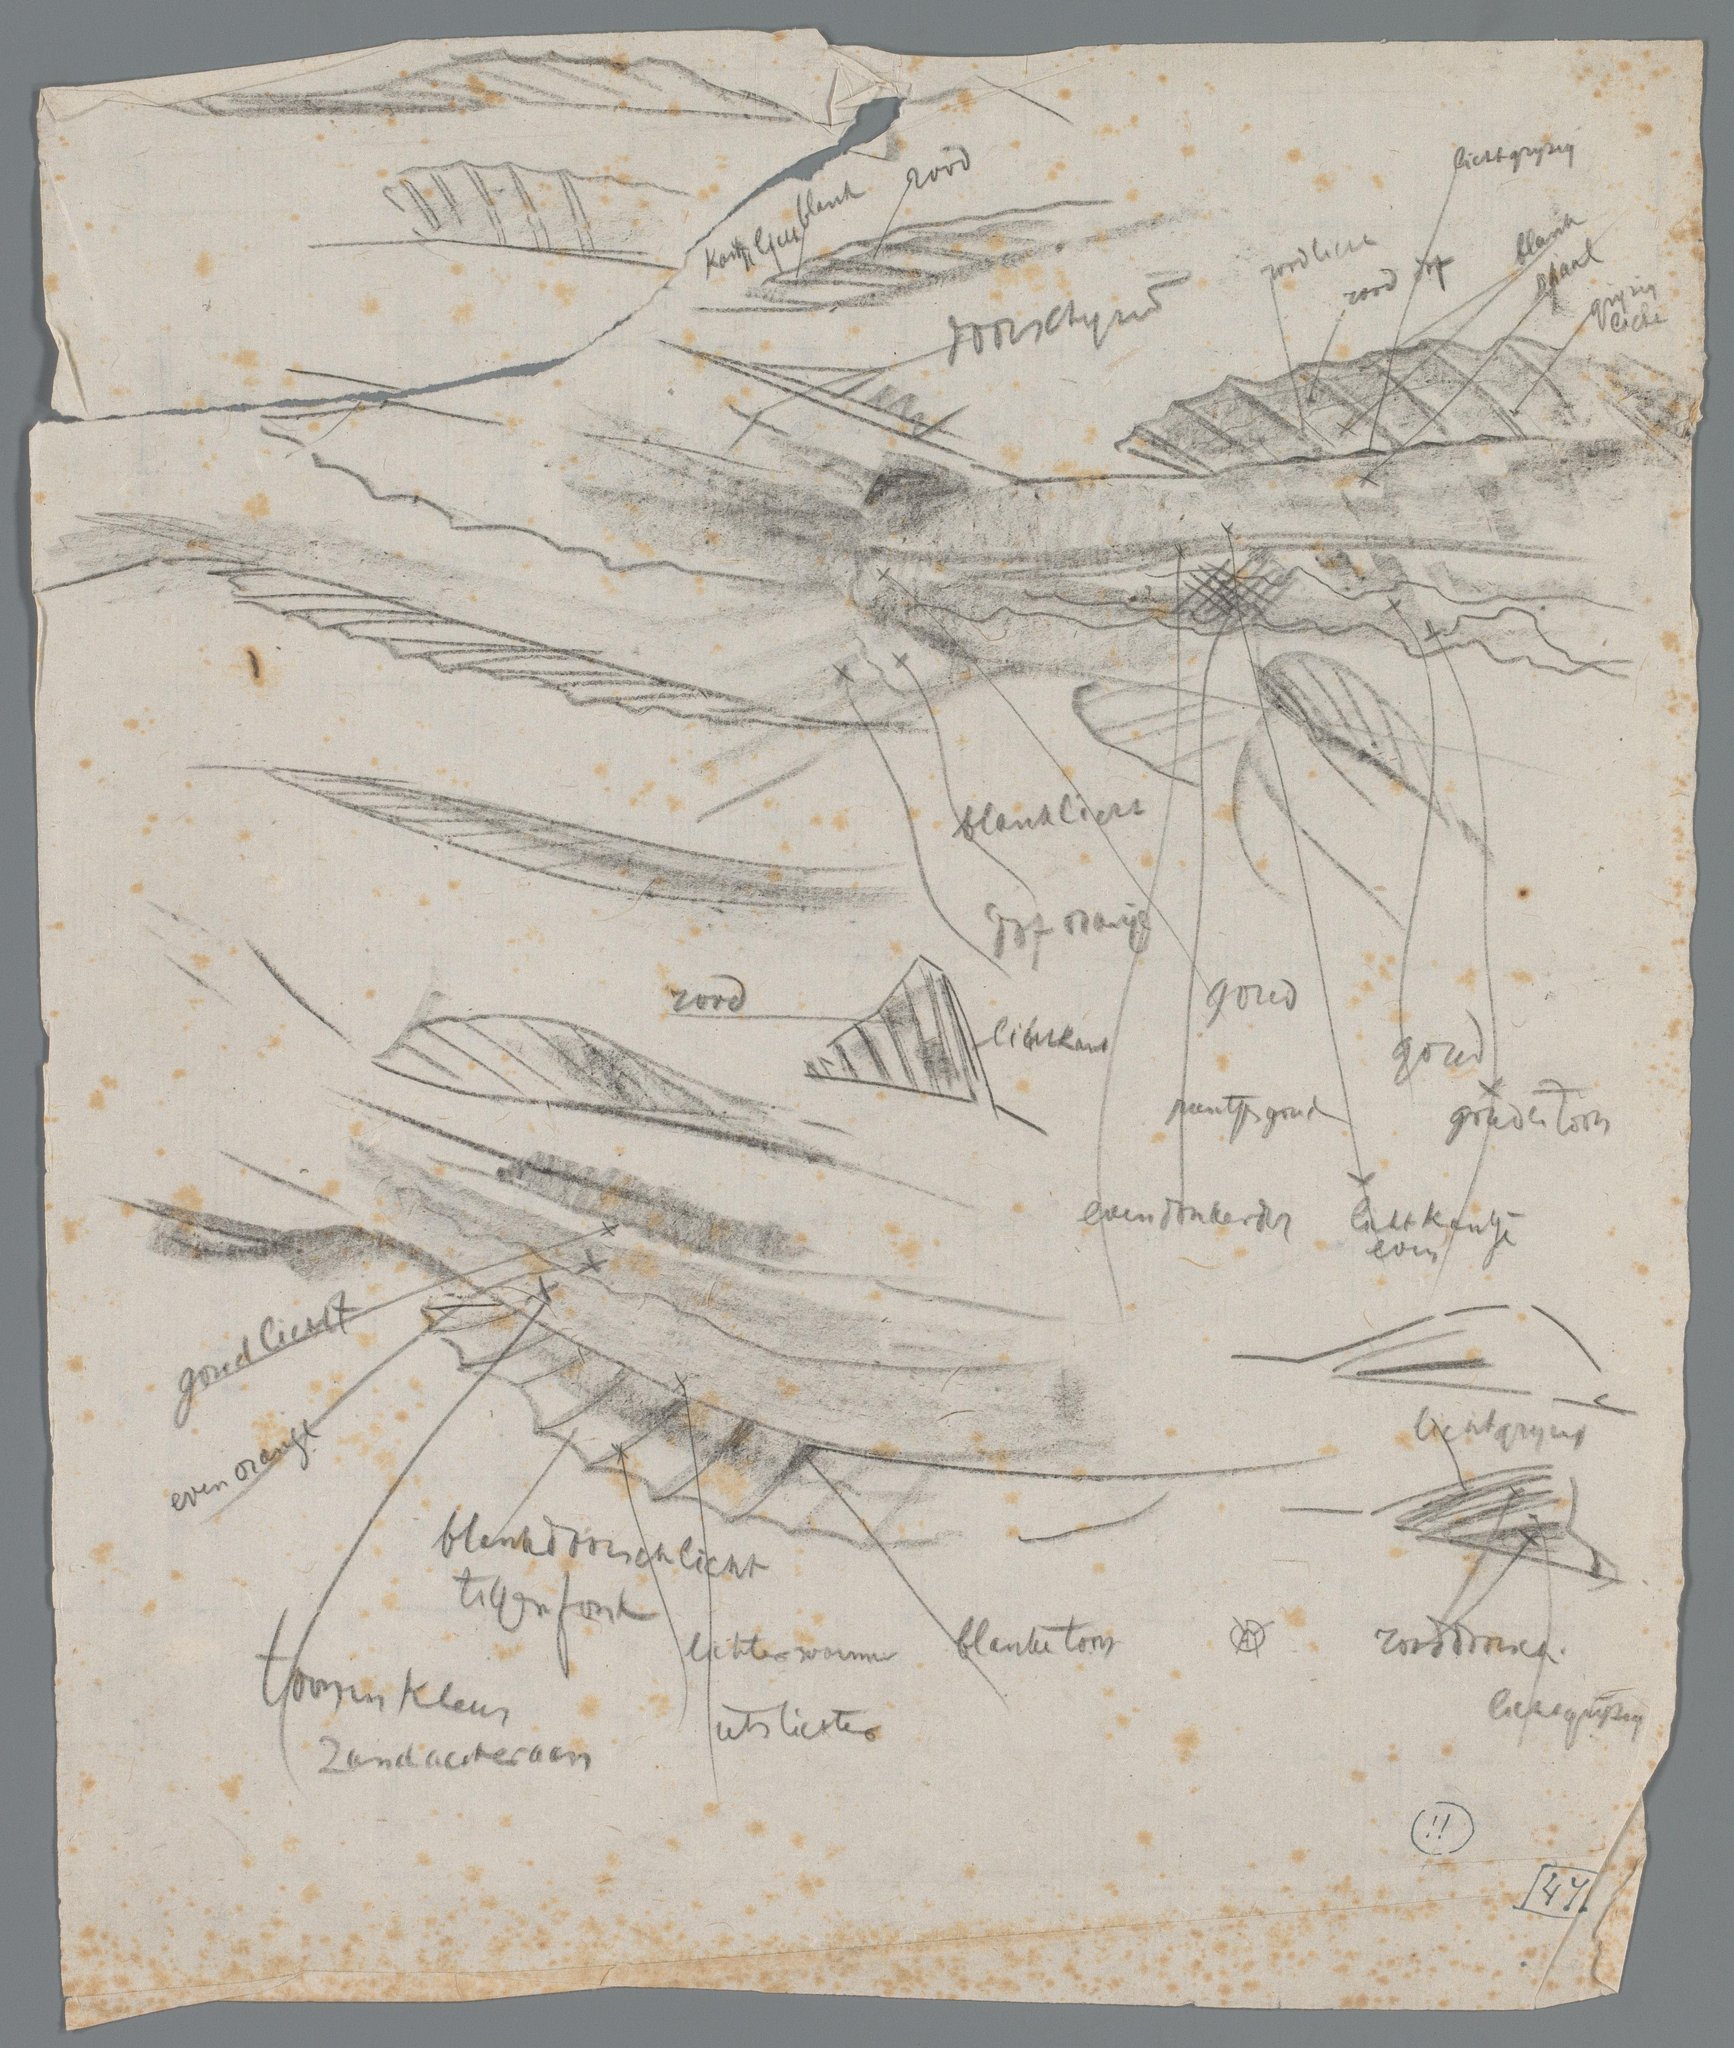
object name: drawing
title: Studieblad met de vinnen van een rode poon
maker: gerrit willem dijsselhof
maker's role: designer, draughtsman, print maker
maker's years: 1866-1924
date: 1876-1924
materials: chalk, paper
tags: fishes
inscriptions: number: ‘11’, number: ‘471’